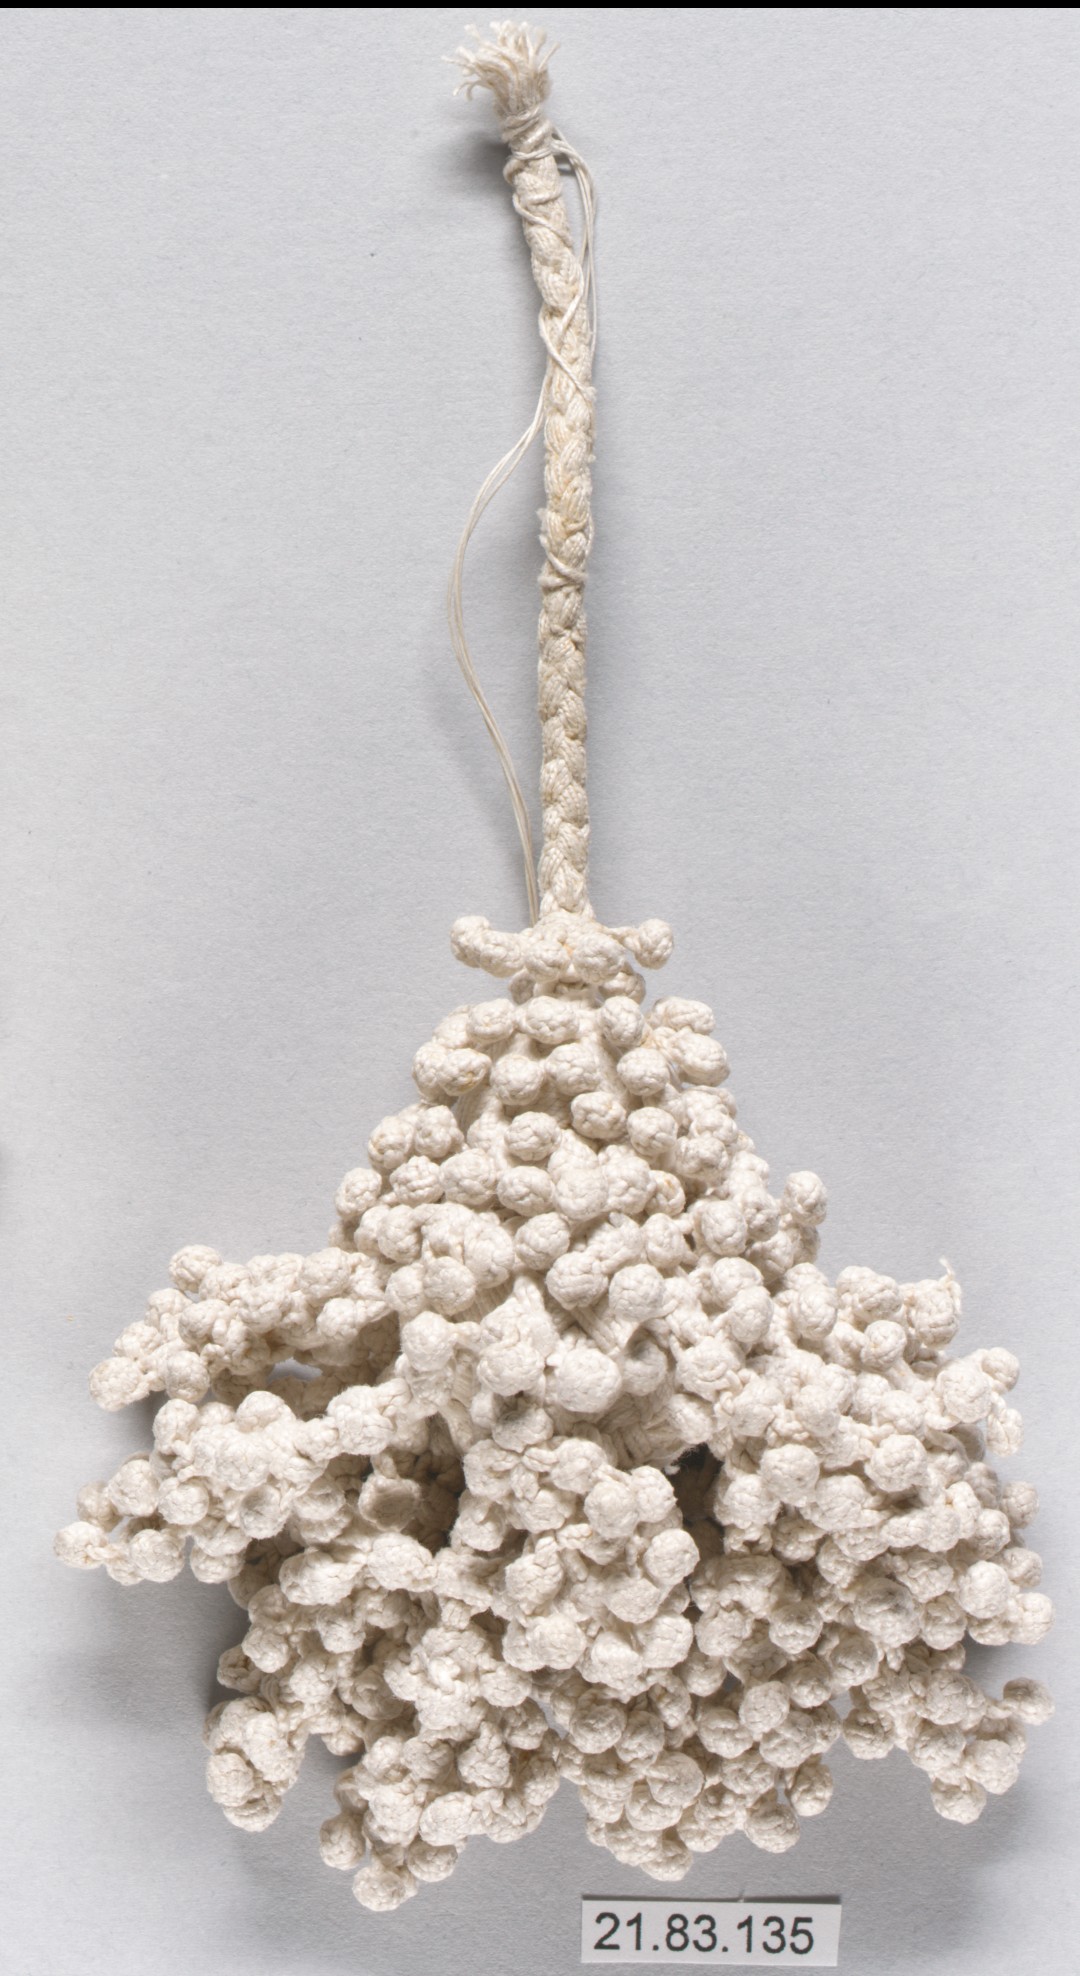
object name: tassel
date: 1601-1700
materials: linen